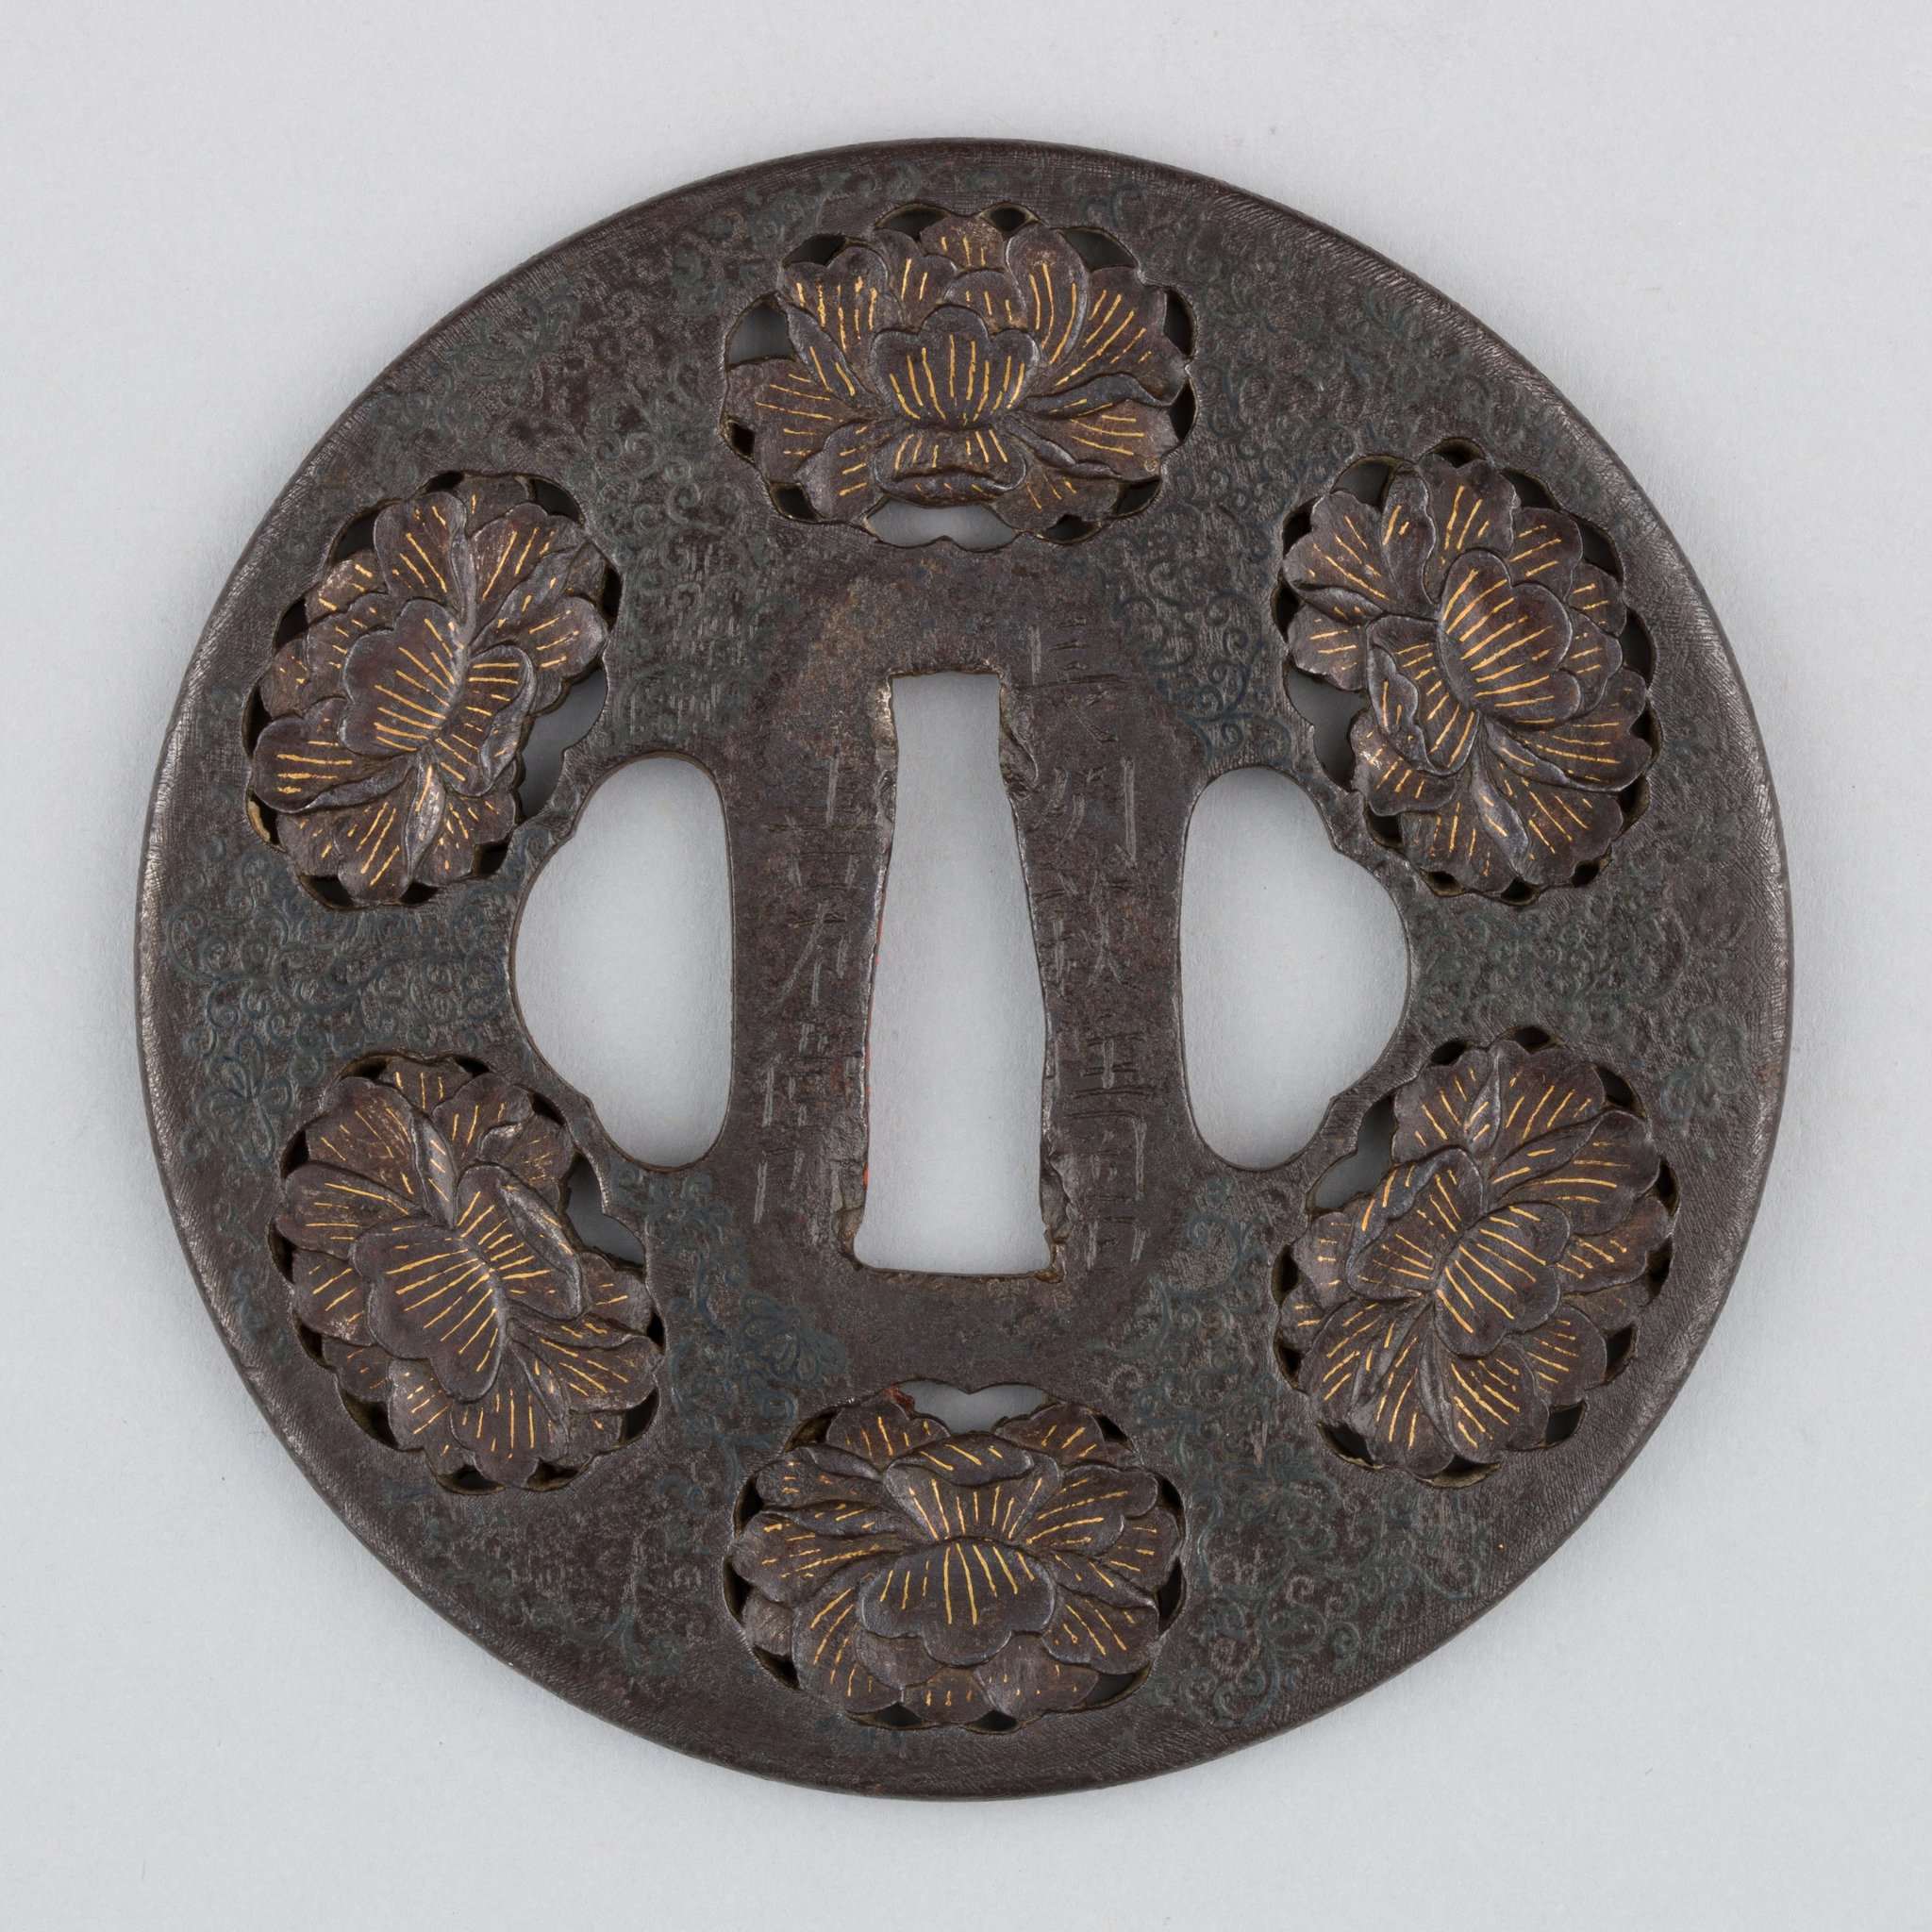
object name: sword guard tsuba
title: Sword Guard (Tsuba)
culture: japanese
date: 1701-1800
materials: copper, gold, iron, silver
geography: japan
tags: flowers